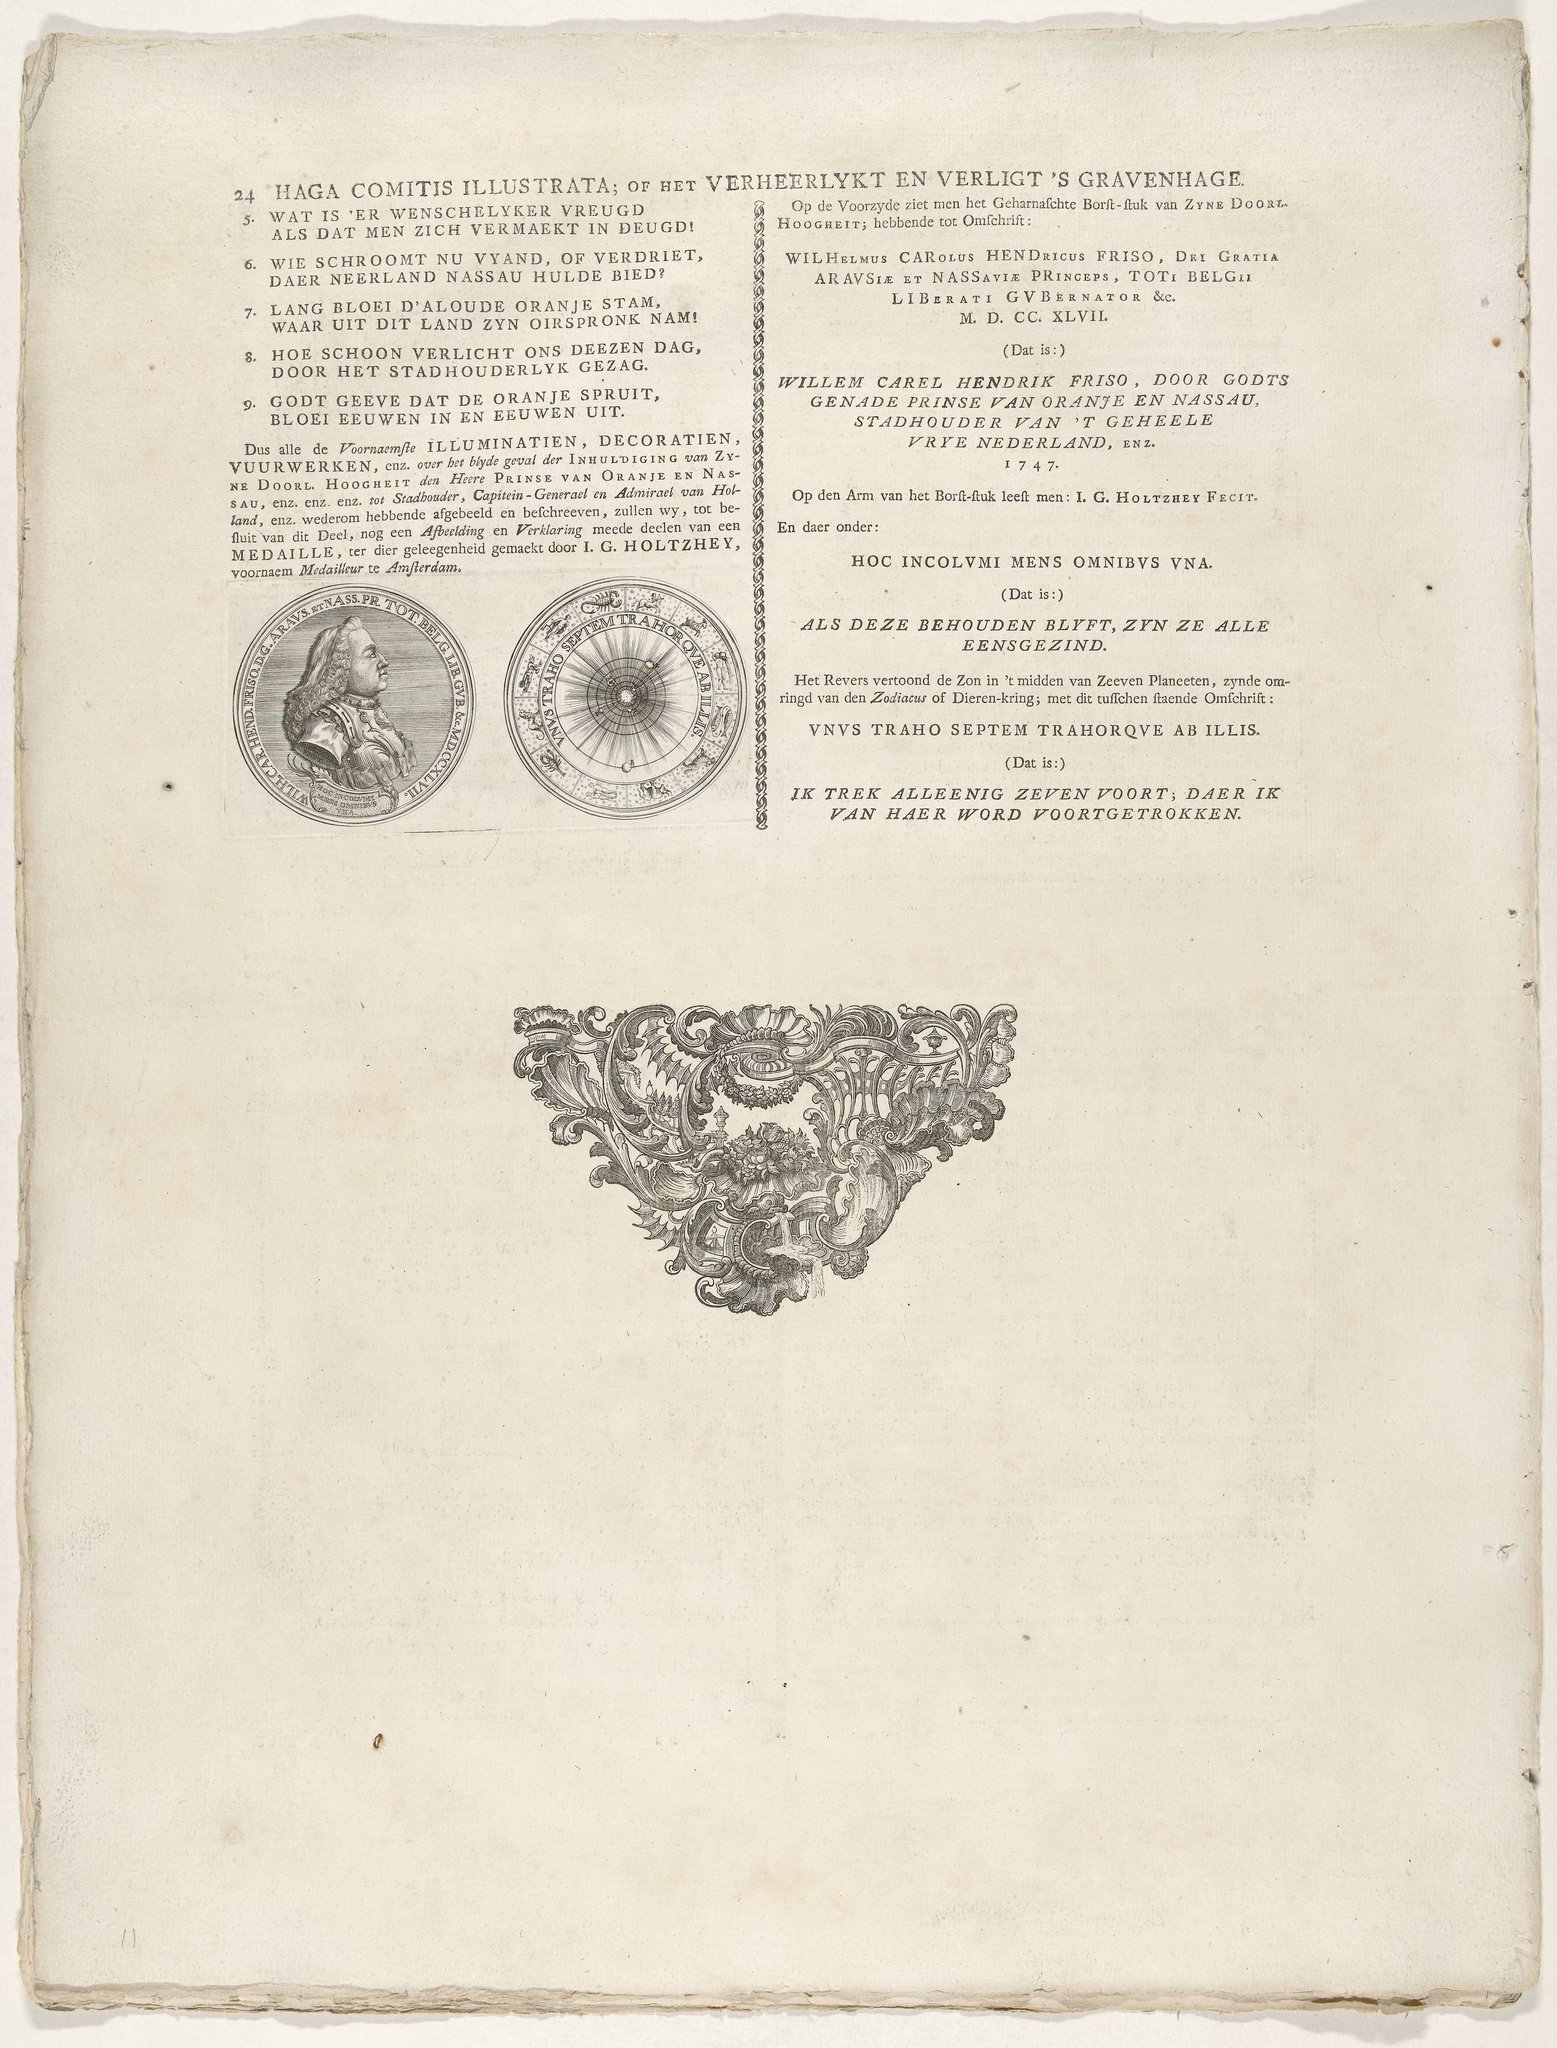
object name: text sheet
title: Laatste blad in: Haga comitis illustrata; of het verheerlykt en verligt 's Gravenhage, 's-Gravenhage 1751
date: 1751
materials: paper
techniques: engraving, etching, letterpress printing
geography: northern netherlands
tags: willem iv (prins van oranje-nassau), medal (considered as a piece of sculpture, regardless of its specific function), the hague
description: Laatste tekstblad (pag. 24) in het tweede tekstdeel met tekst in twee kolommen met een voorstelling van een penning van stadhouder Willem IV en onderaan een ornamentaal vignet met rocailles. Los blad oorspronkelijk onderdeel van het plaatwerk Haga comitis illustrata uit 1751 met de versieringen opgesteld te Den Haag tijdens de feestelijkheden rond de installatie van prins Willem IV als stadhouder van Holland en West-Friesland op 3 en 15 mei 1747.